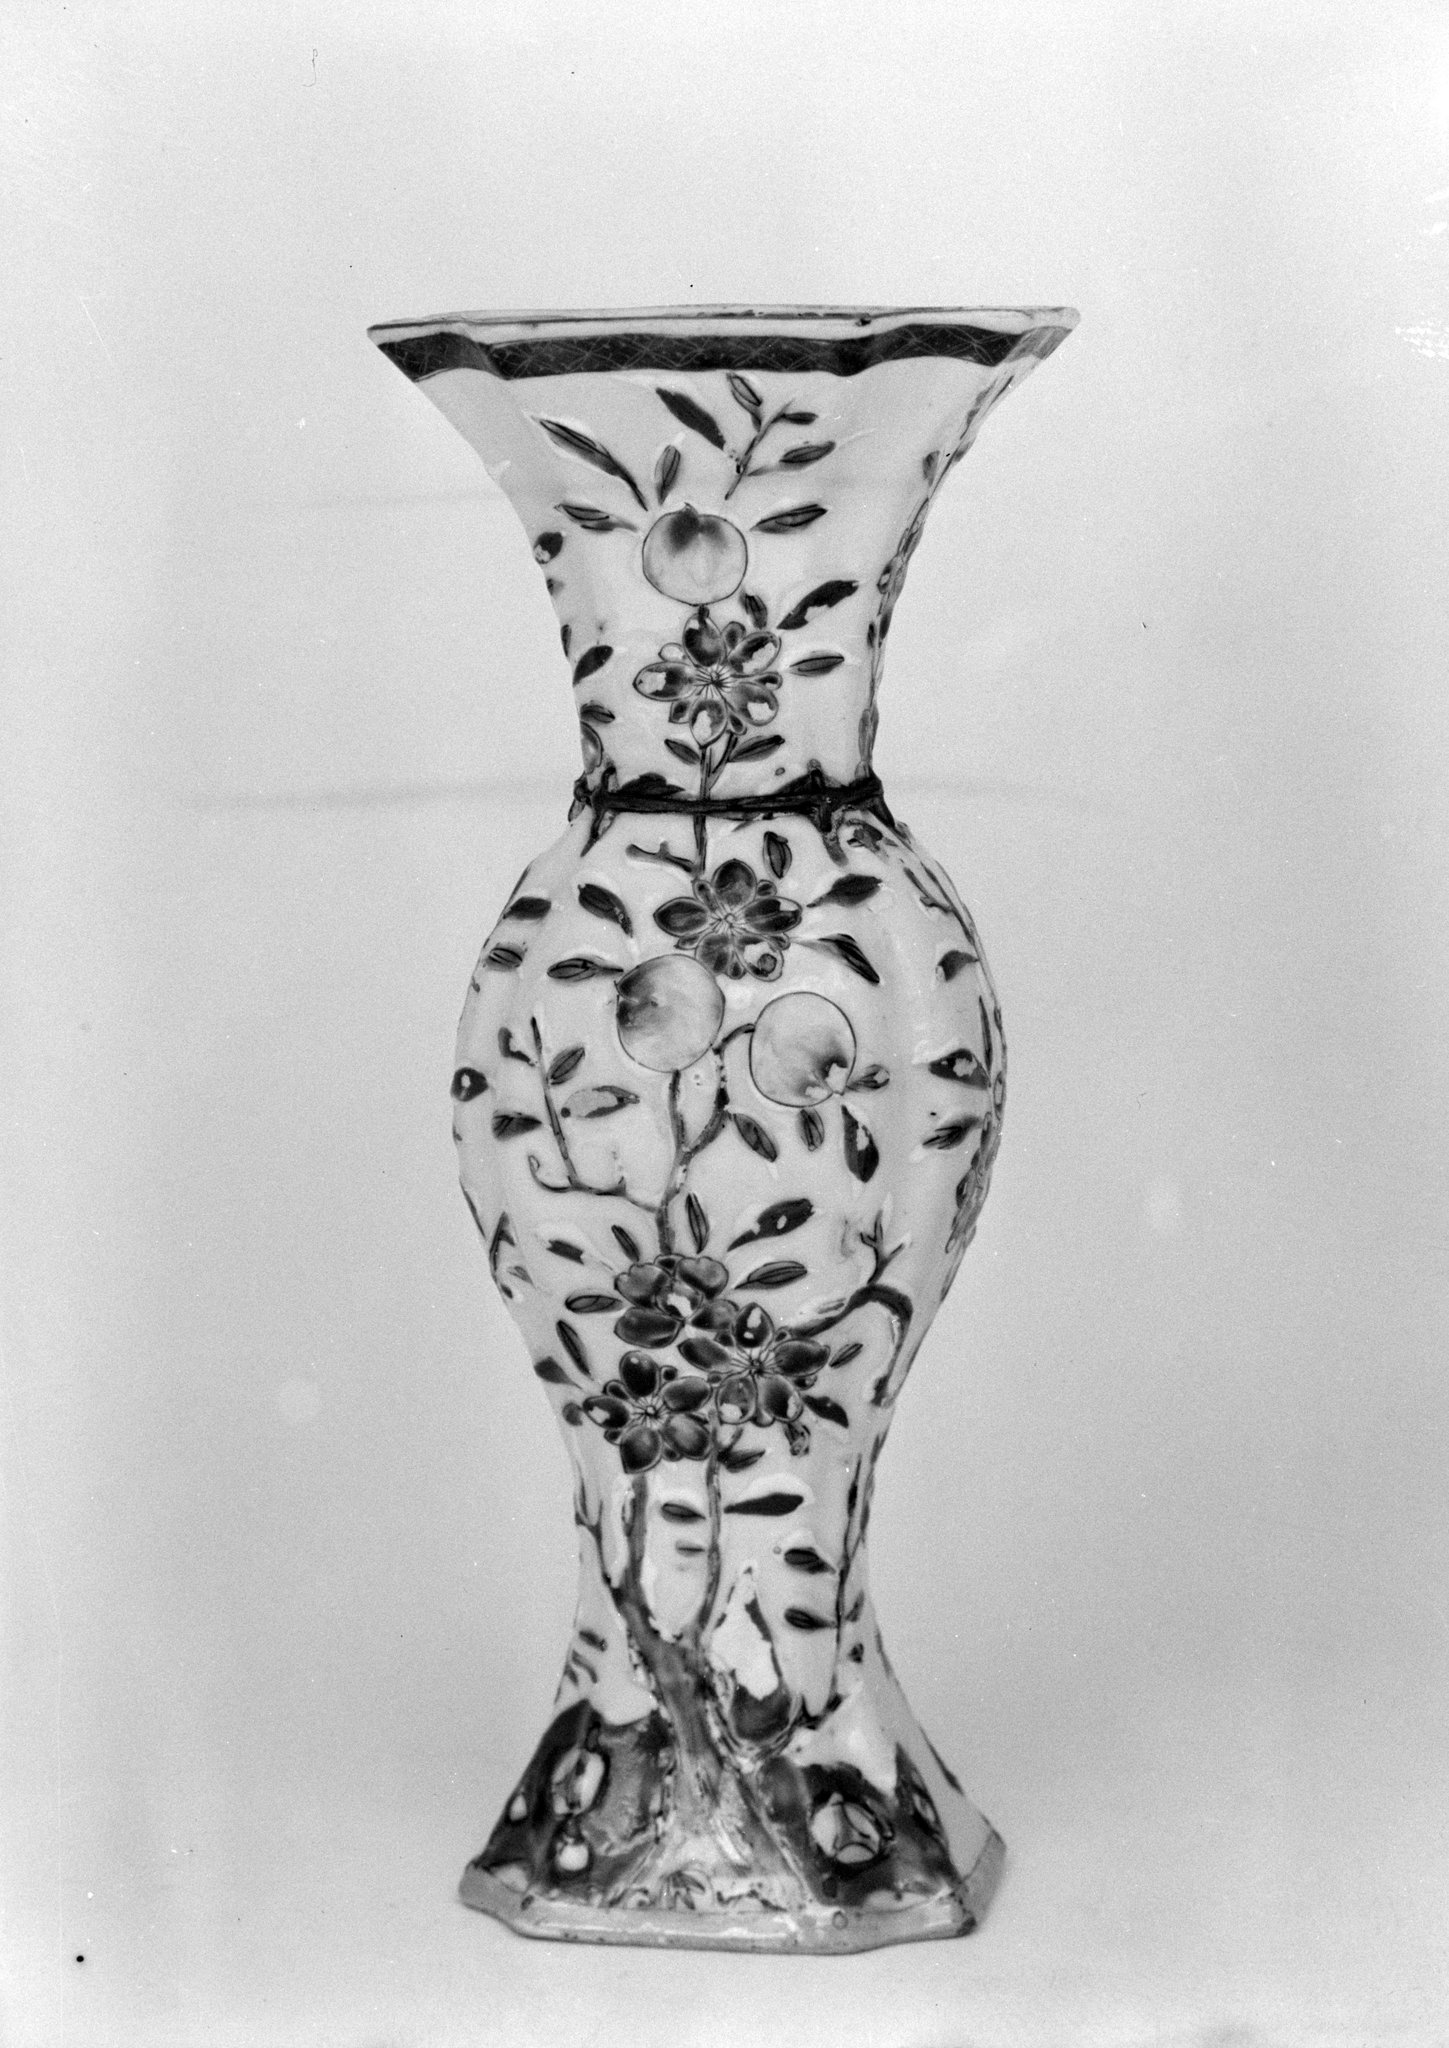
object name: vase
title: Vase (one of two)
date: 1734-1766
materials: hard paste porcelain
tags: fruit,flowers